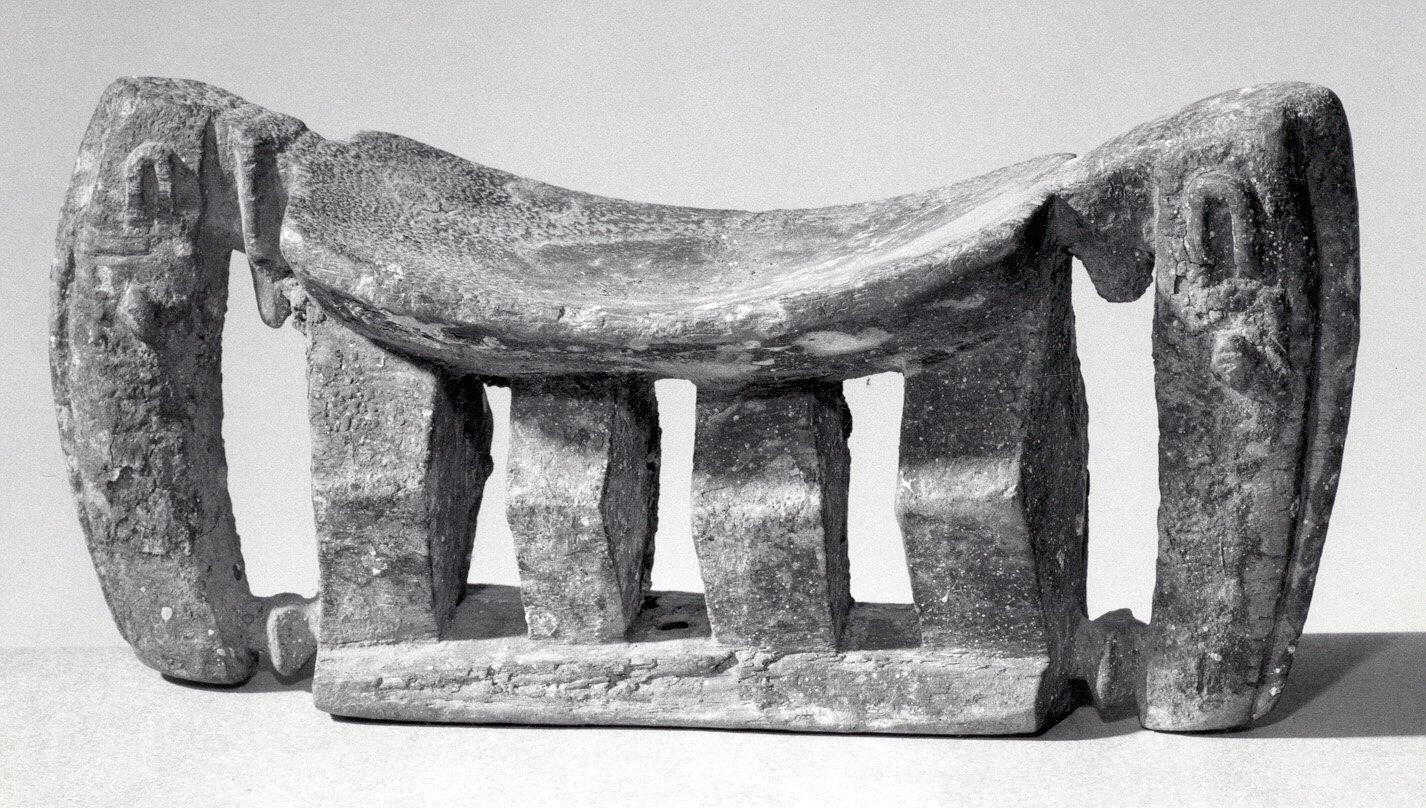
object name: headrest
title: Headrest: Zoomorphic Heads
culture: dogon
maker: dogon blacksmith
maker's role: artist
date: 1401-1900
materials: patina, pigment, wood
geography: mali